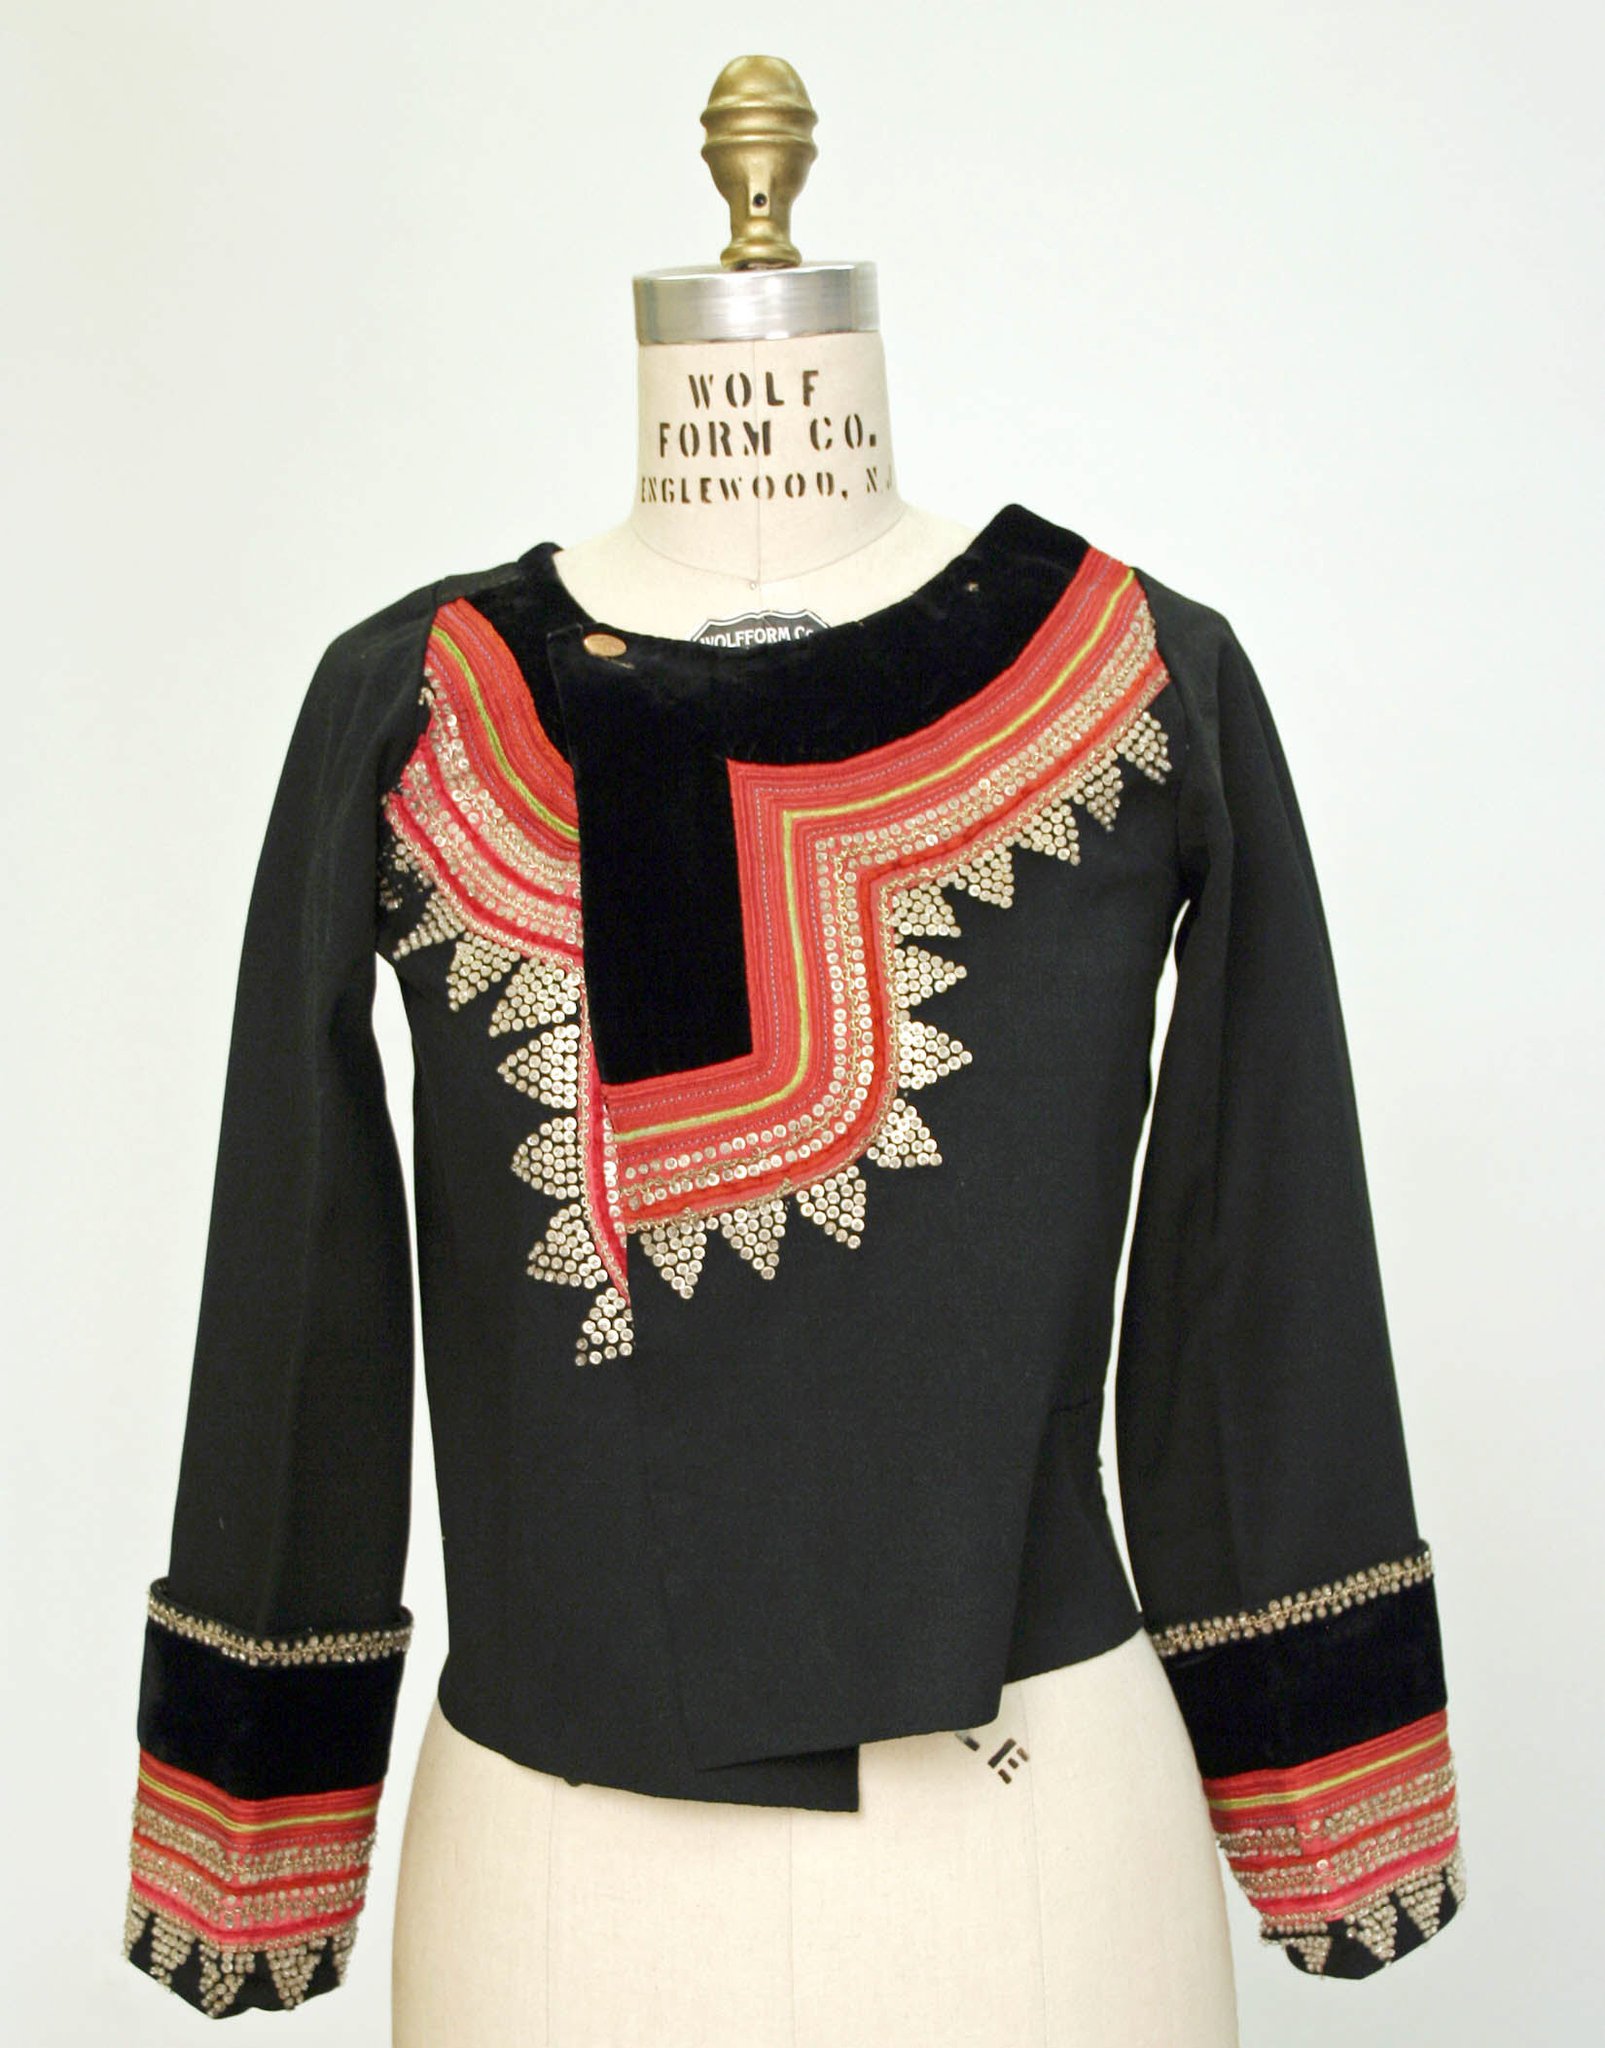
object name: jacket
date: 1801-1900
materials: glass, metal thread, thread, wool